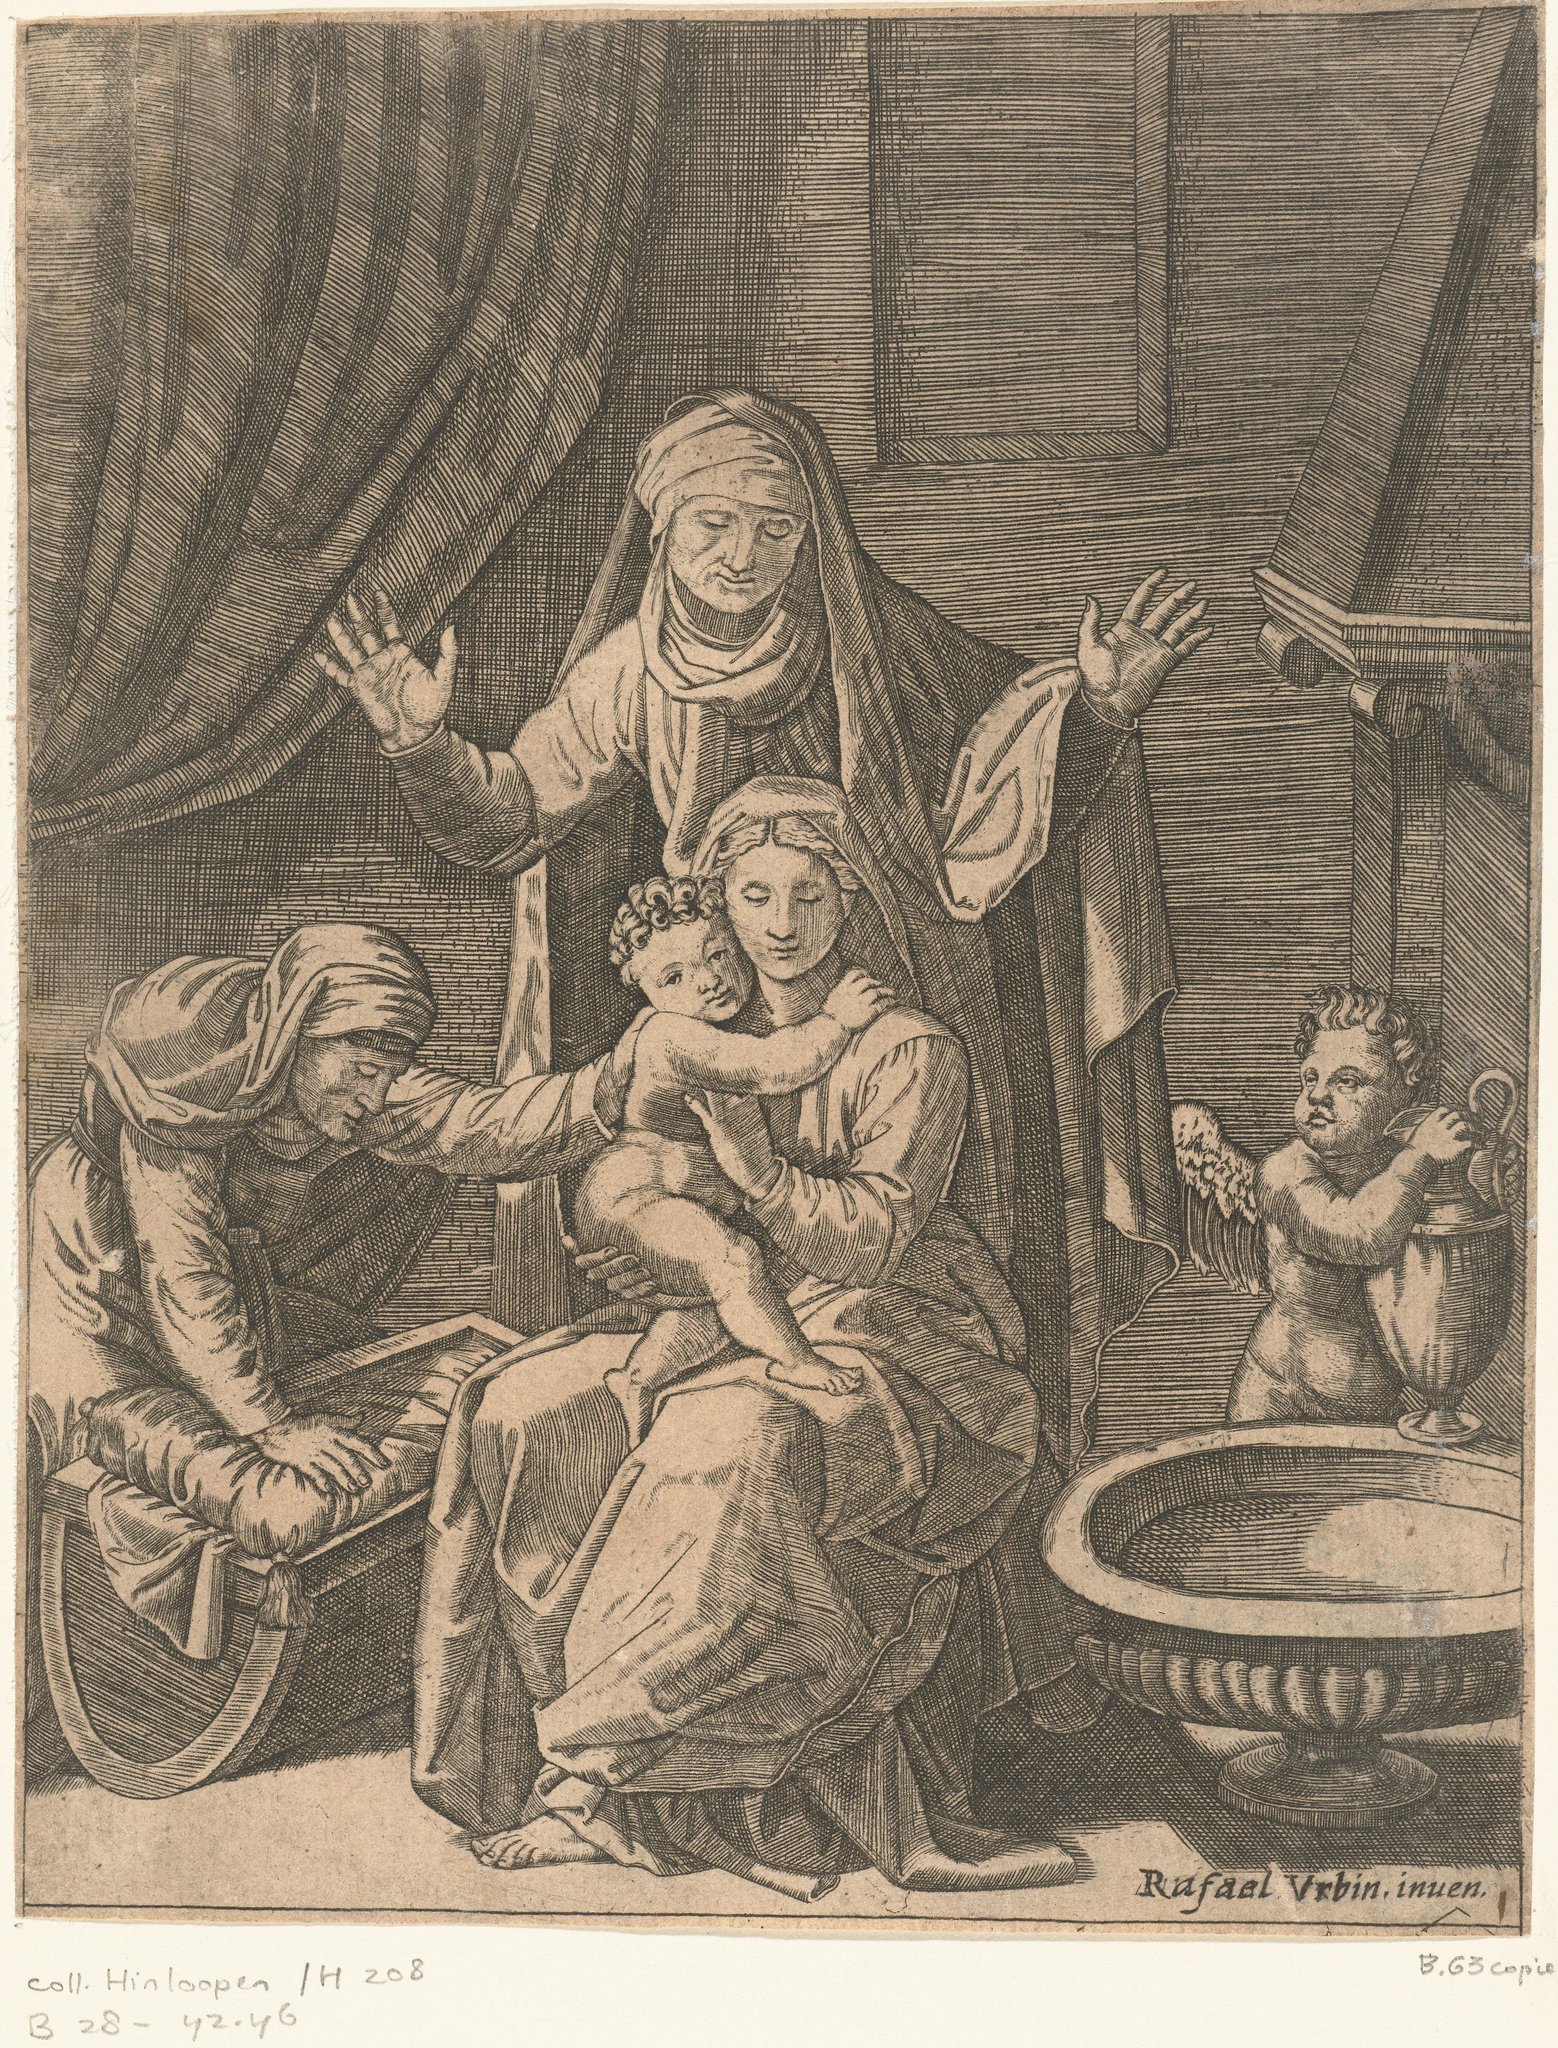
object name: print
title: Maria met kind en heiligen Anna en Elisabet bij wieg en engel met waterkan bij schaal met water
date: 1599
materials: paper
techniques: engraving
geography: italy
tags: 'anna selbviert' (emerentia, anna, mary, christ-child), cradle, crib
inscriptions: collector's mark: Lugt 10, inscription: ‘B 28 f 42-46’, collector's mark: Lugt 11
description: Kopie naar prent van Marcantonio Raimondi. Raimondi liet zich inspireren door een ontwerp van Raphael.